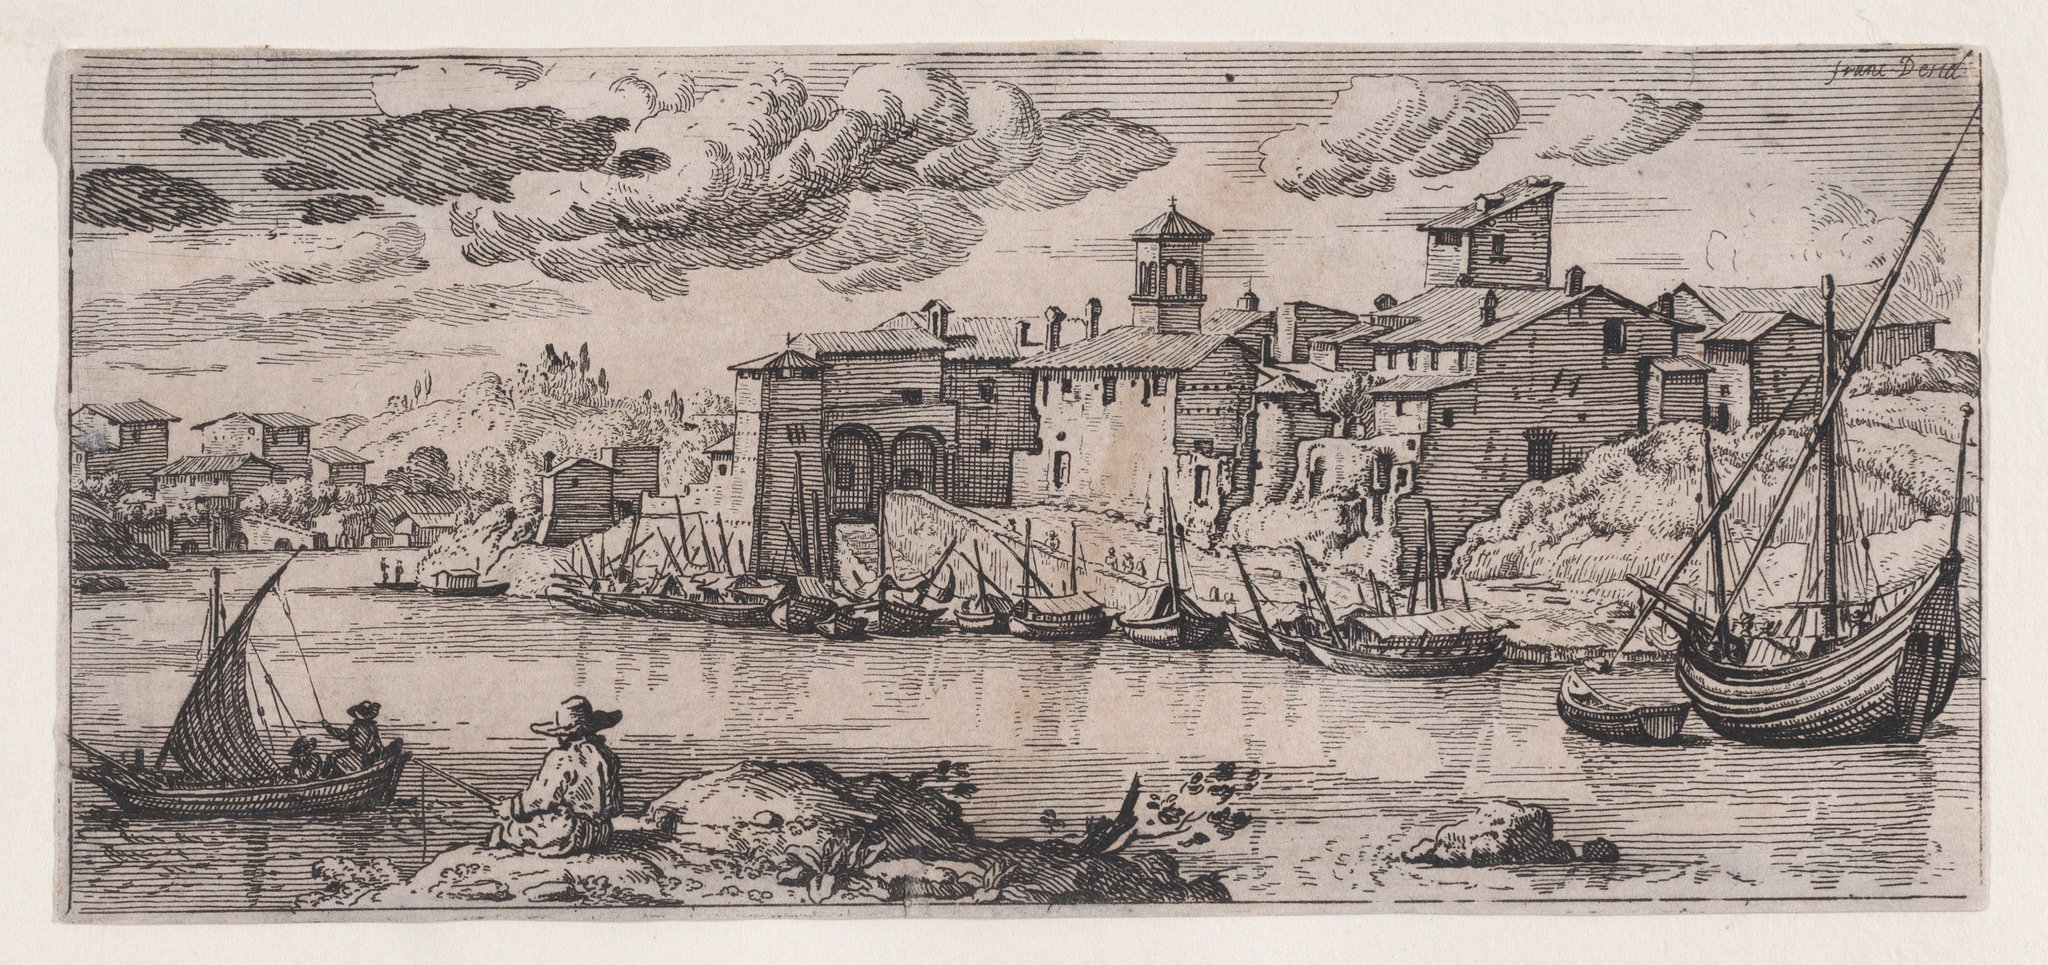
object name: print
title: Fishermen on a river across from a town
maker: Anonymous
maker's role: artist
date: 1601-1700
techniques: etching